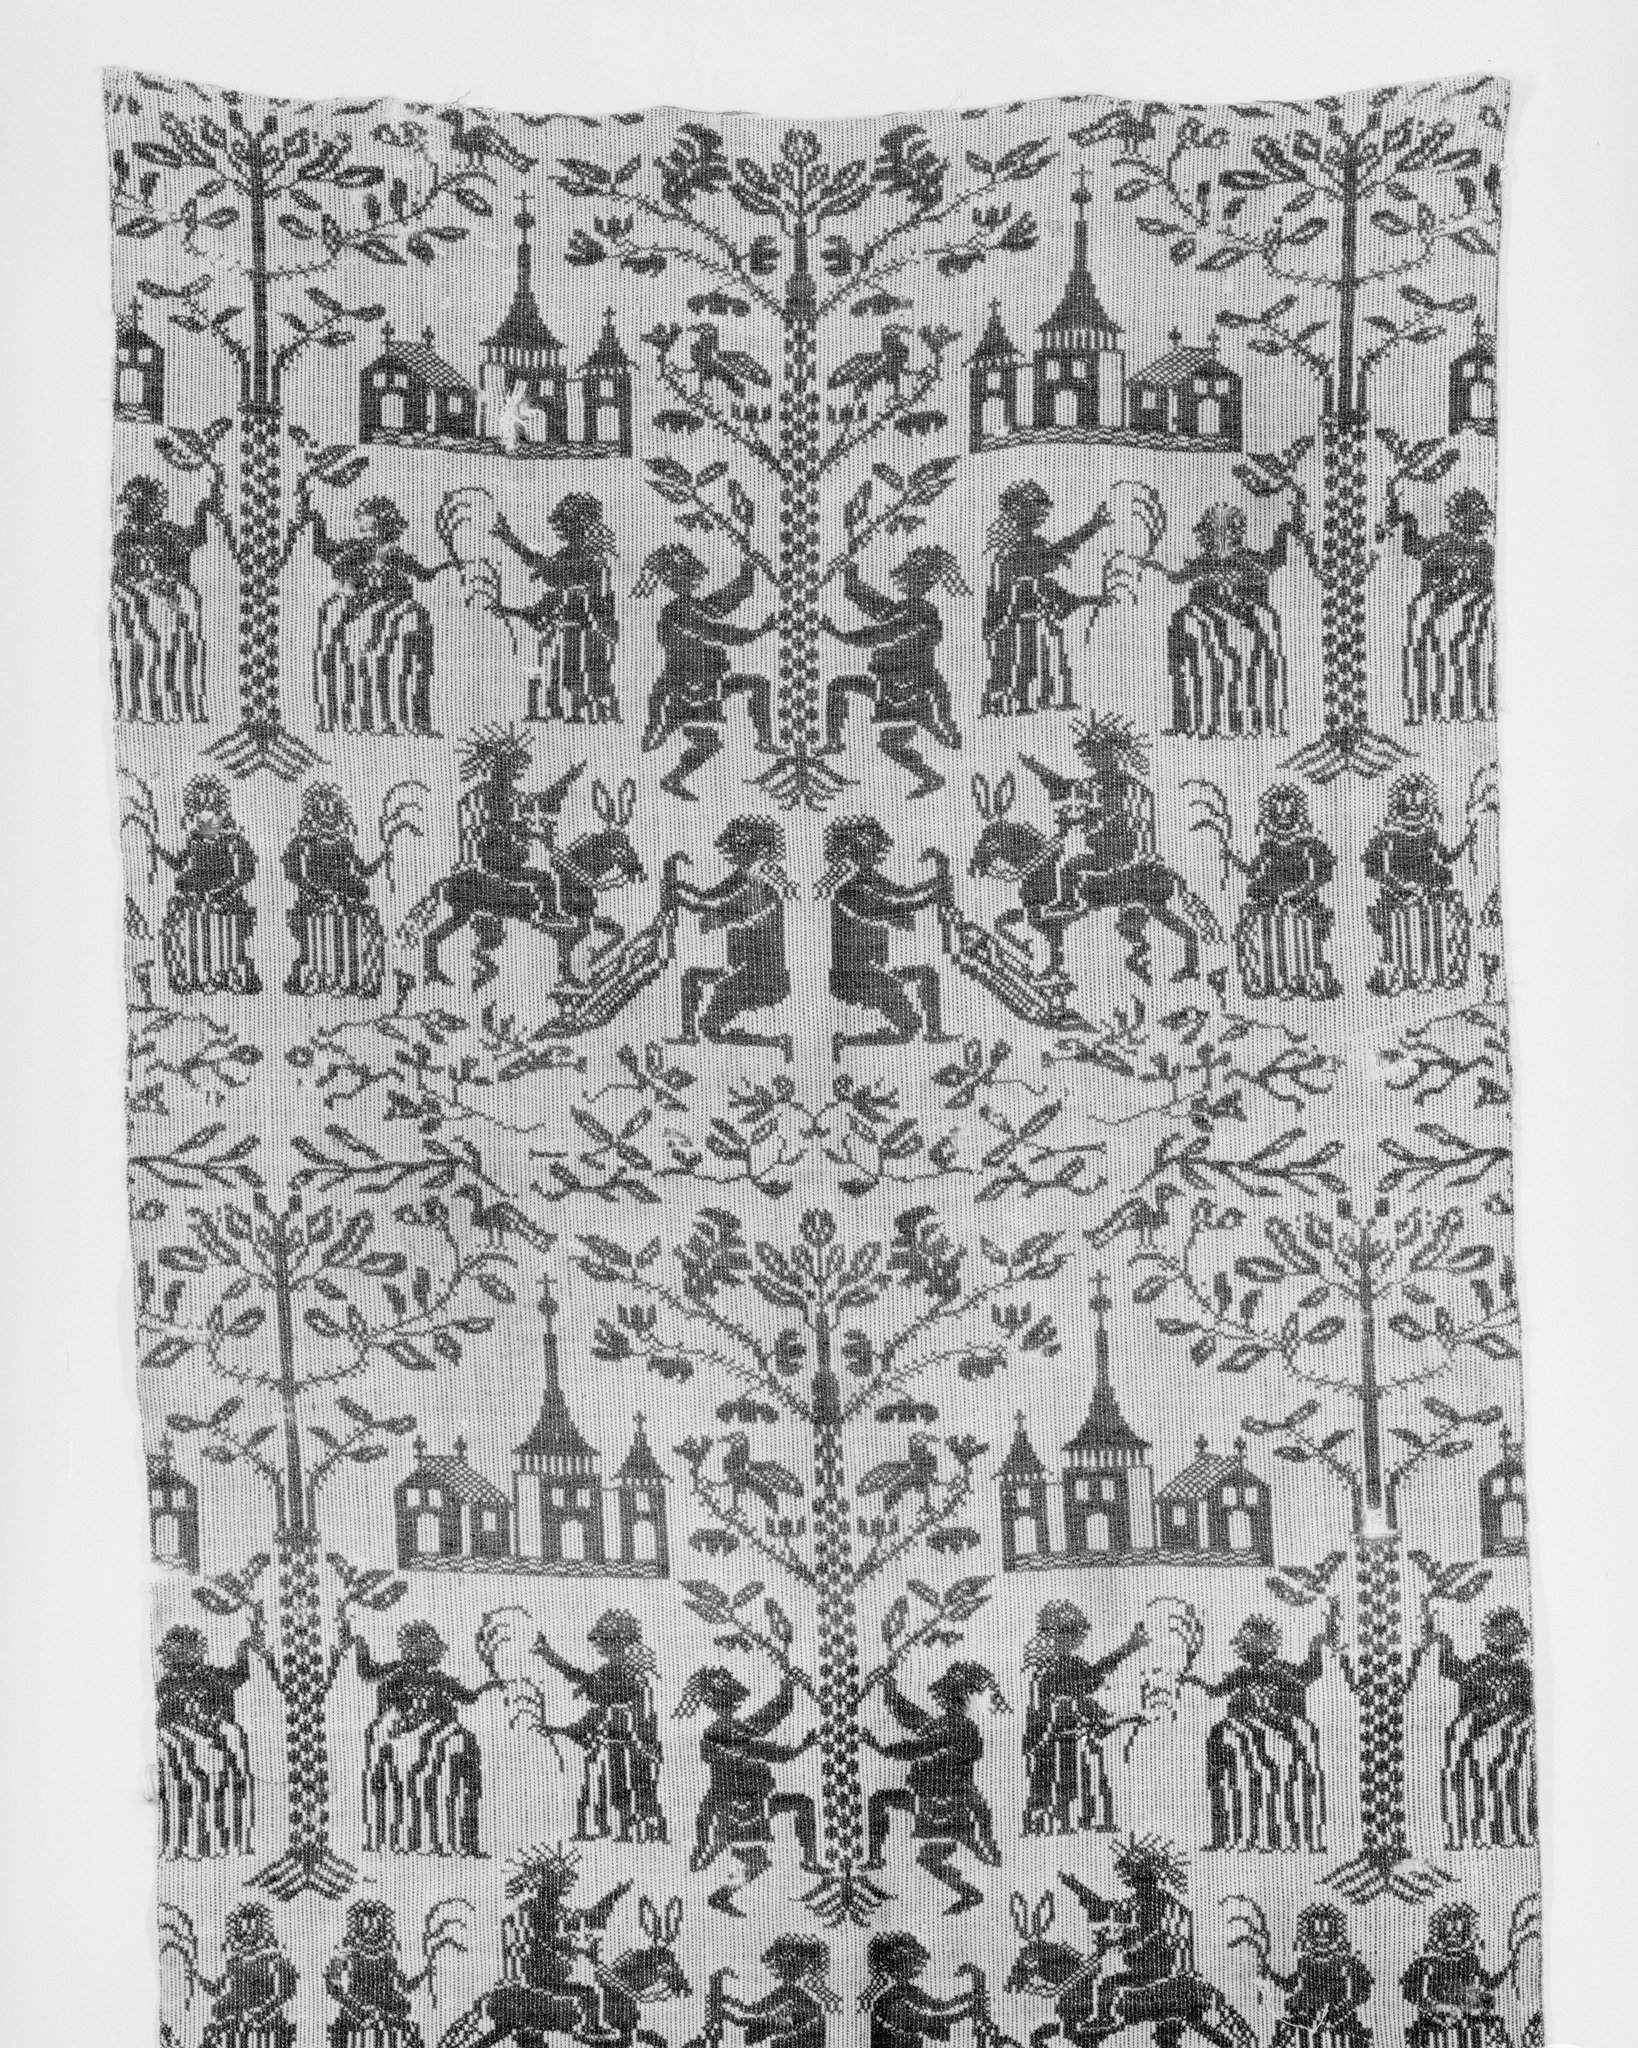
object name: length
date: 1601-1700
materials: cotton, wool